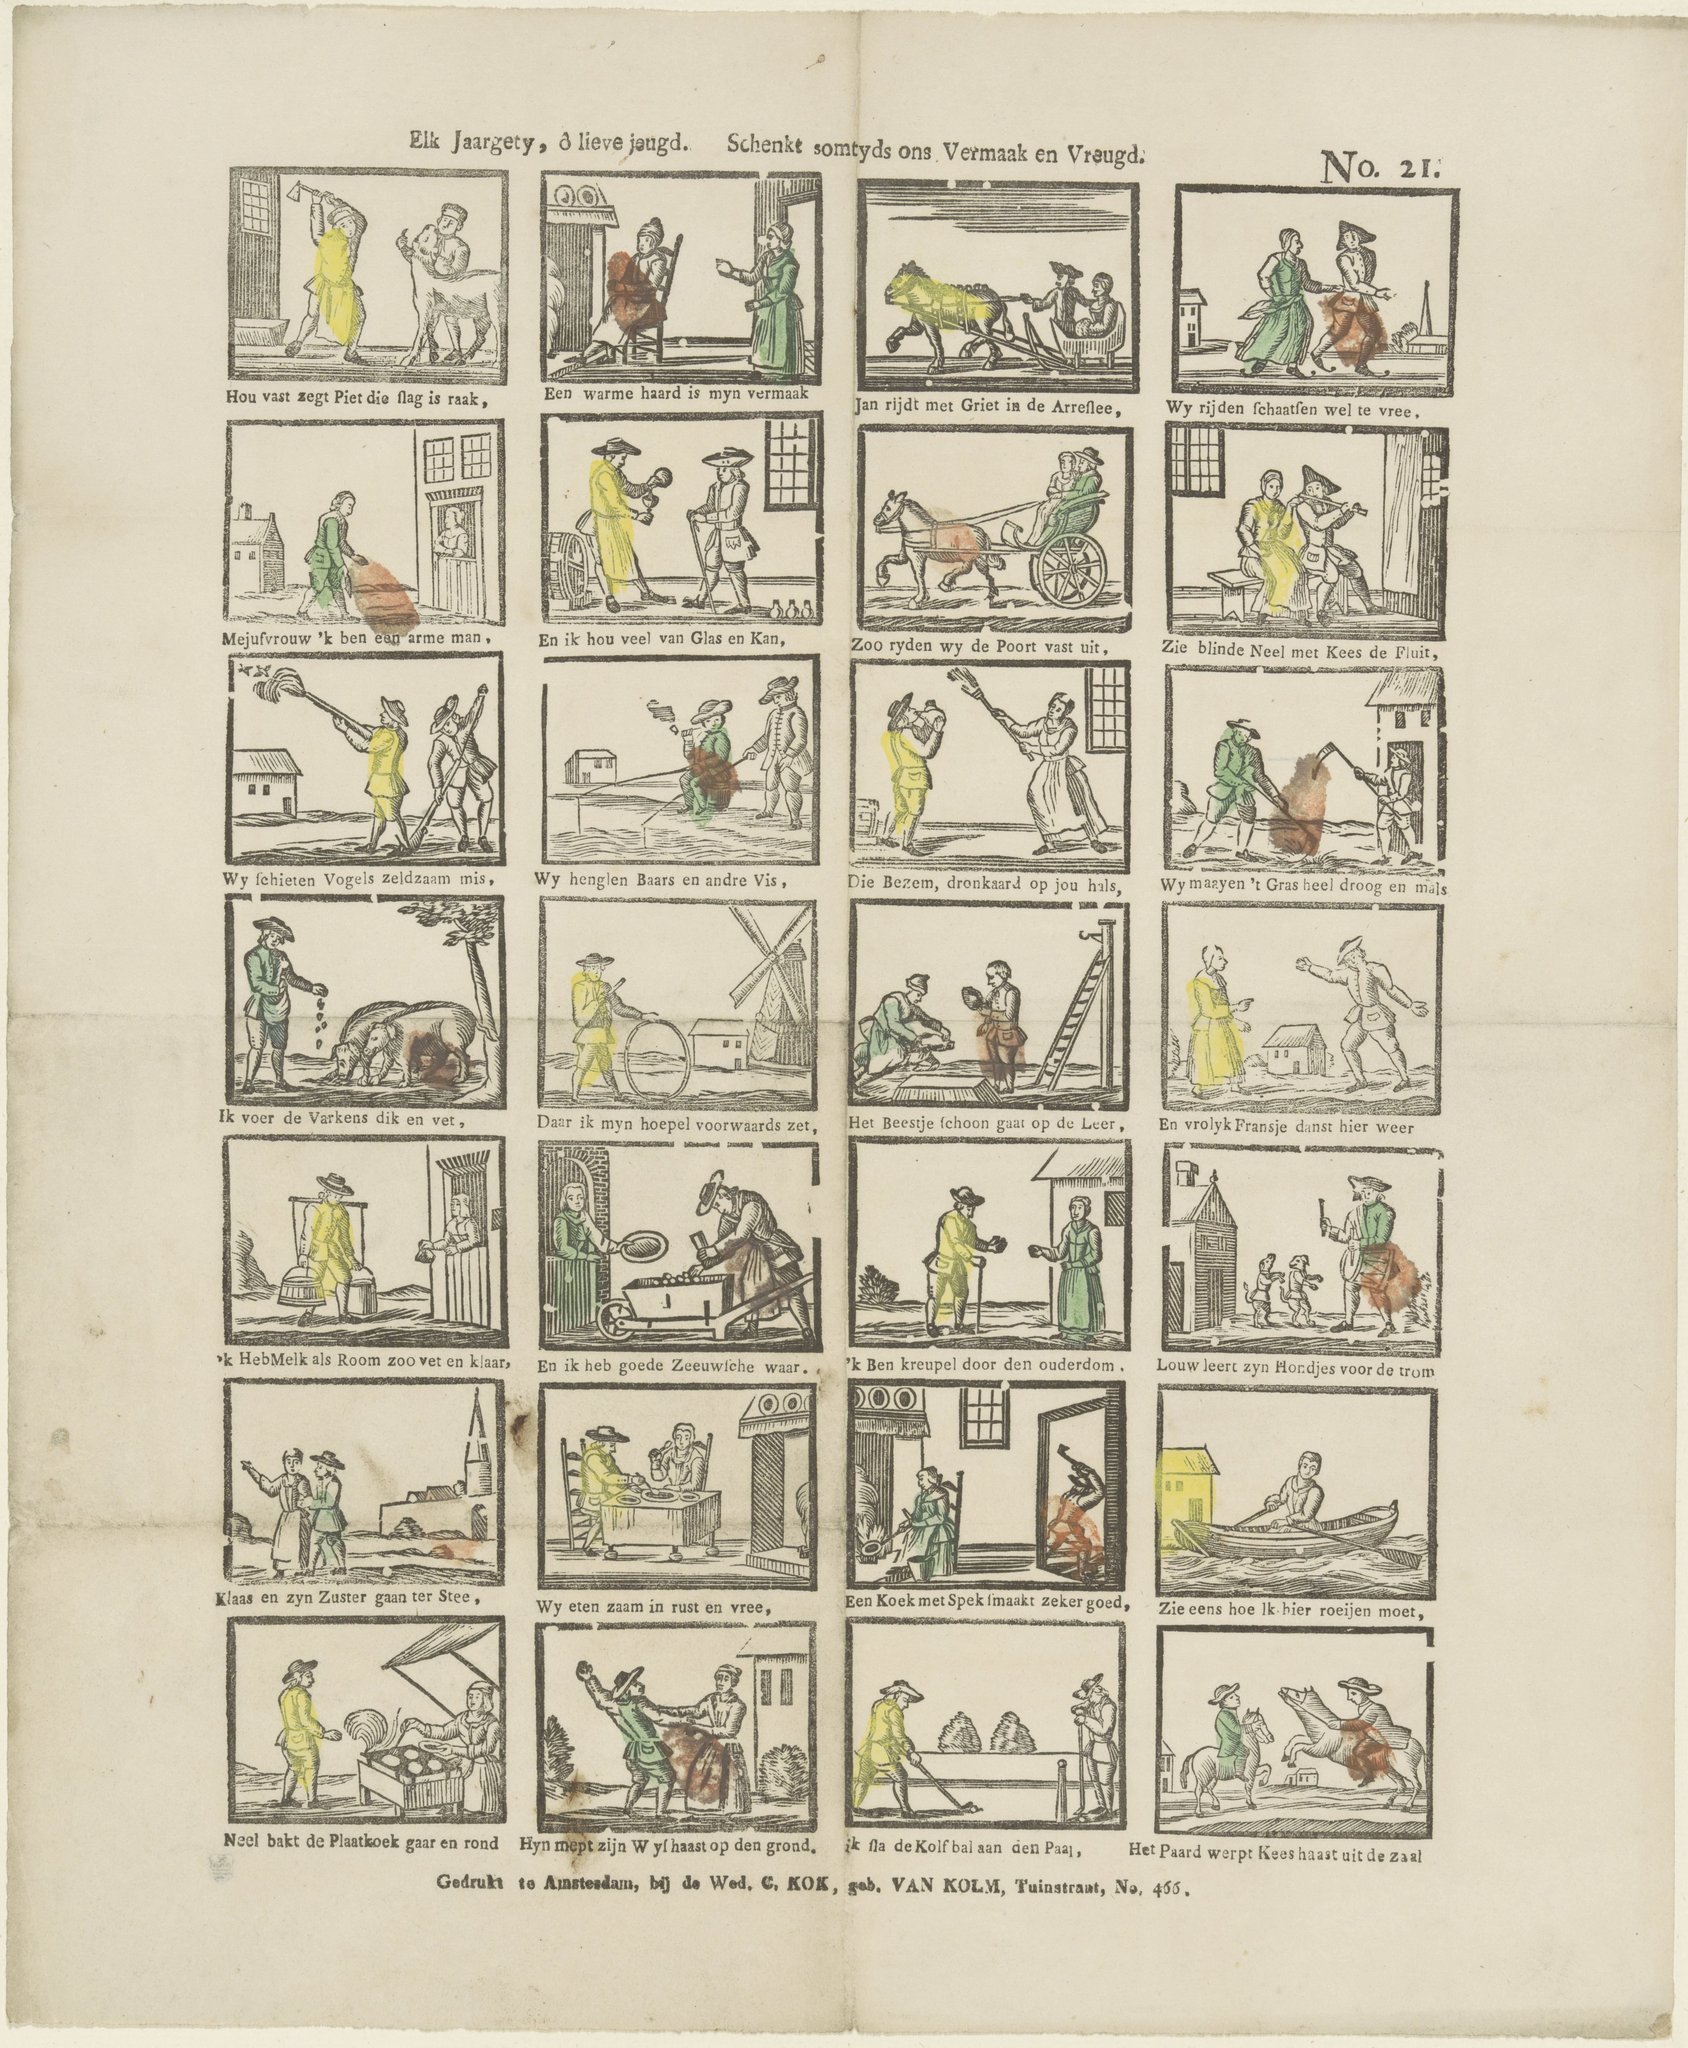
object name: print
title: Elk jaargety, ô lieve jeugd. / Schenkt somtyds ons vermaak en vreugd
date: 1842-1866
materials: paper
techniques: colour, letterpress printing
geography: amsterdam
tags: the four seasons of the year ~ human activities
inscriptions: collector's mark: Lugt 2760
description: Blad met 28 voorstellingen van landelijke taferelen tijdens de verschillende jaargetijden. Onder elke afbeelding een onderschrift. Genummerd rechtsboven: No. 21.